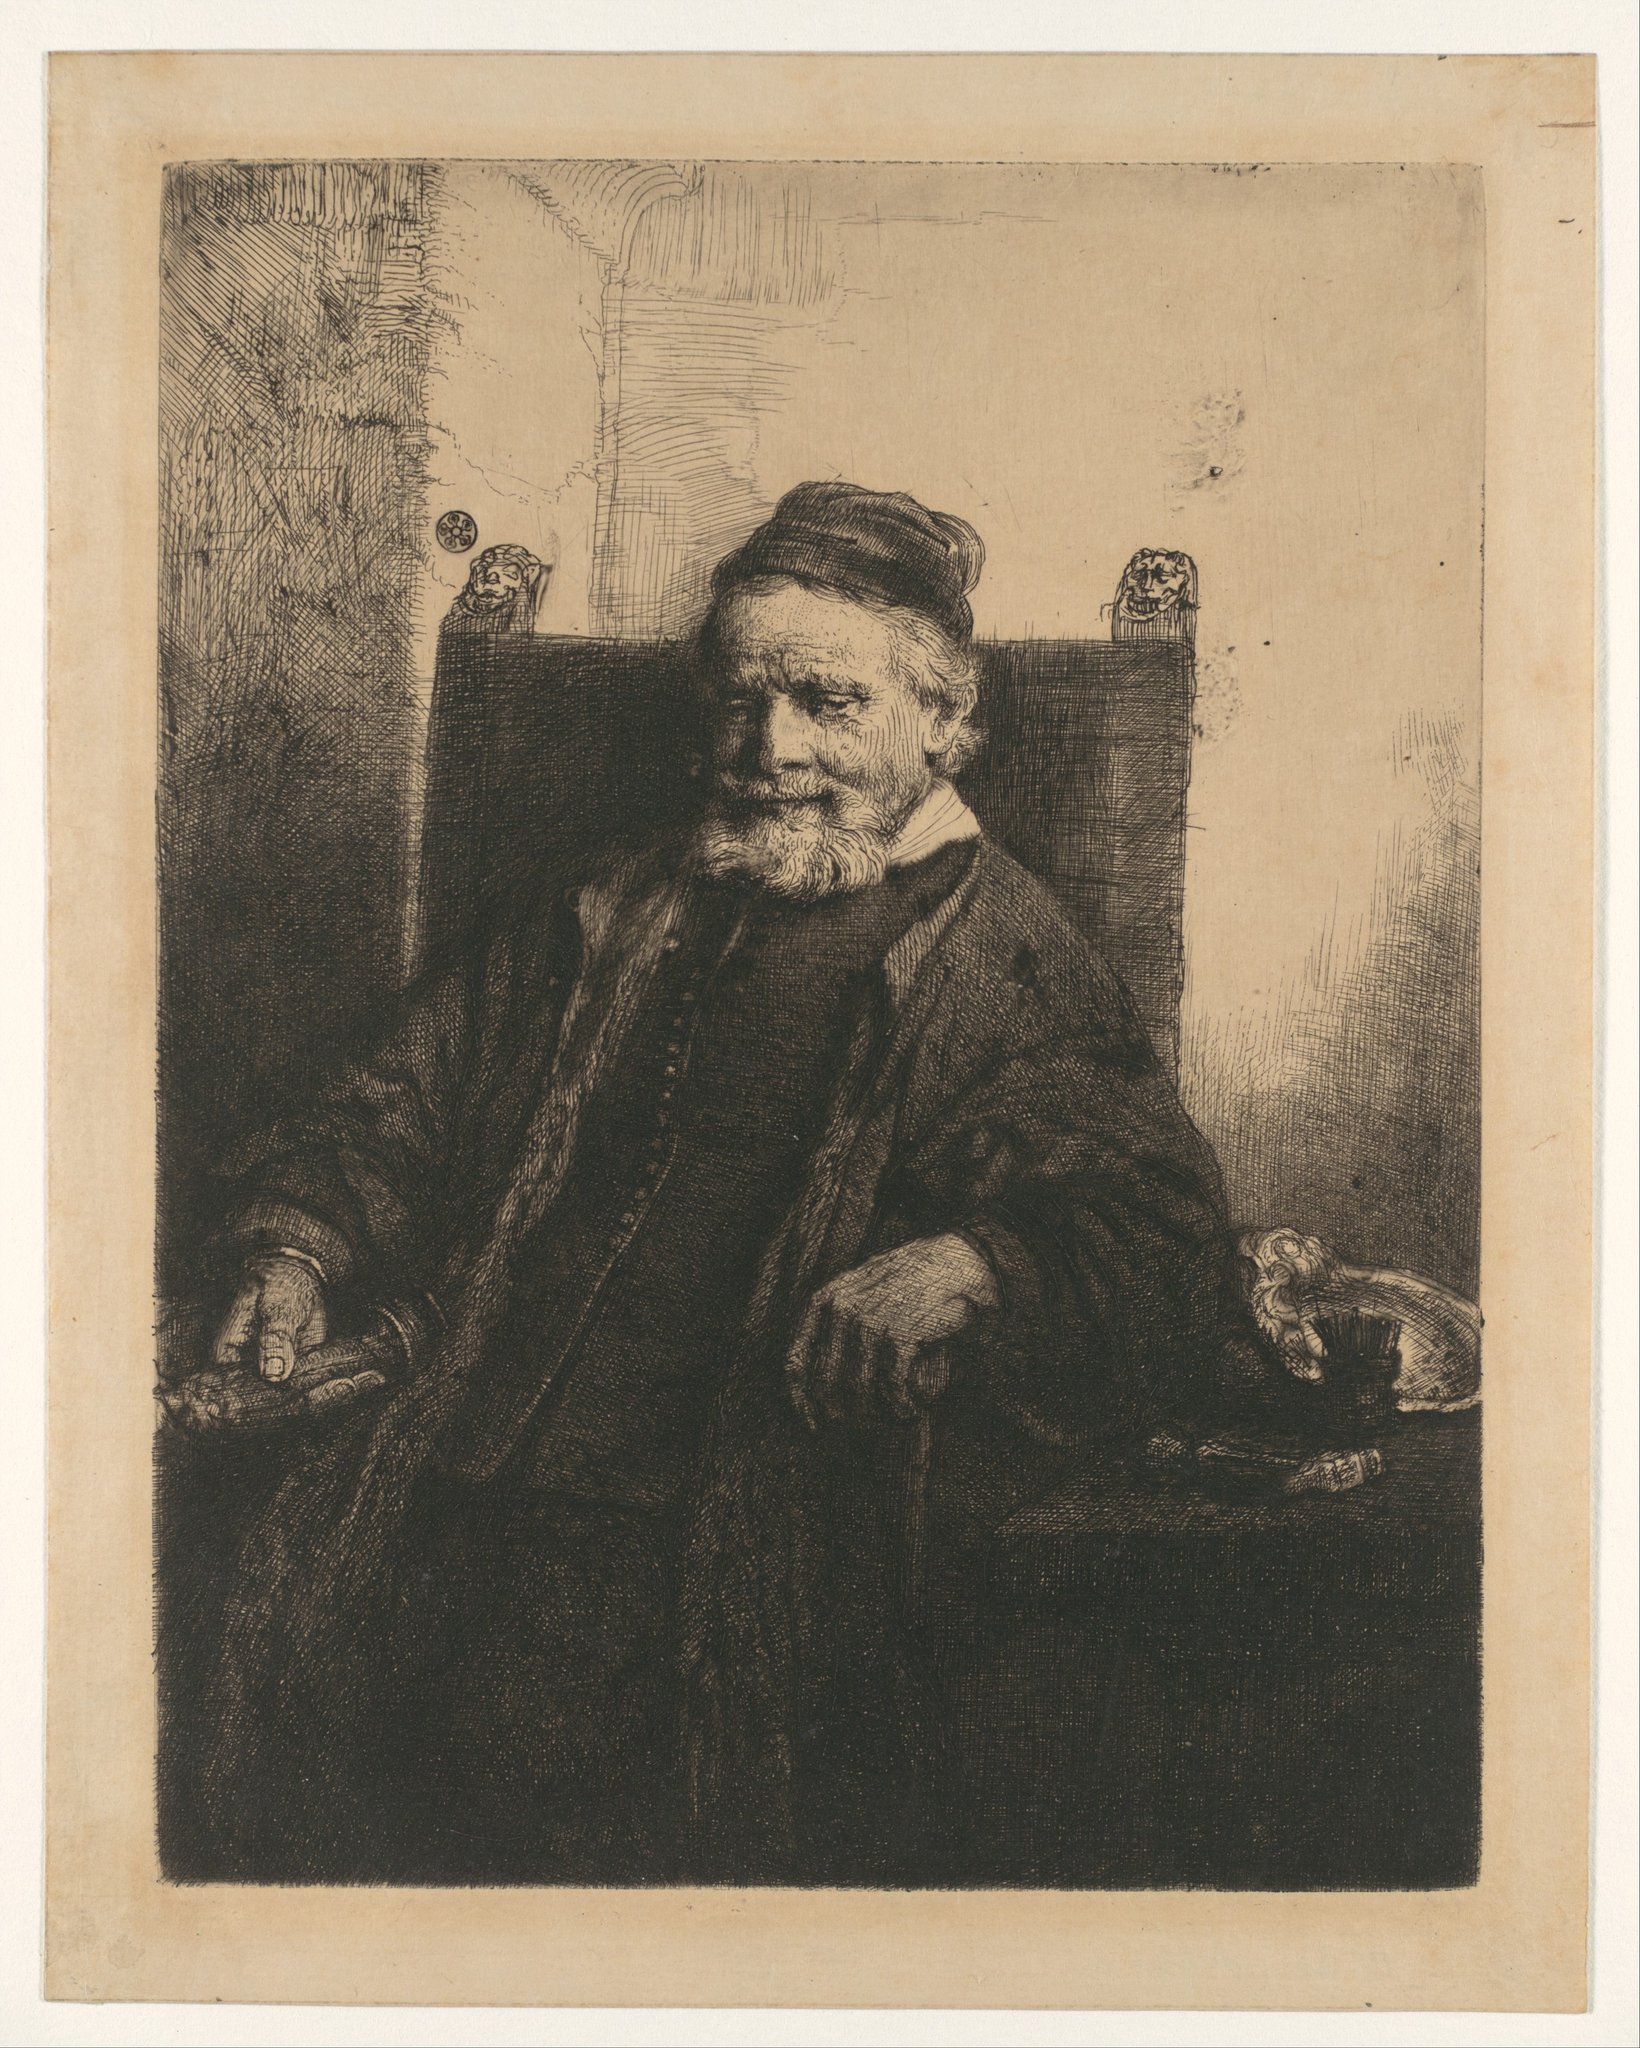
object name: print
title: Jan Lutma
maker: rembrandt van rijn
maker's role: artist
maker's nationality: dutch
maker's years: 1606-1669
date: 1656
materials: paper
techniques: drypoint, engraving, etching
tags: men,portraits